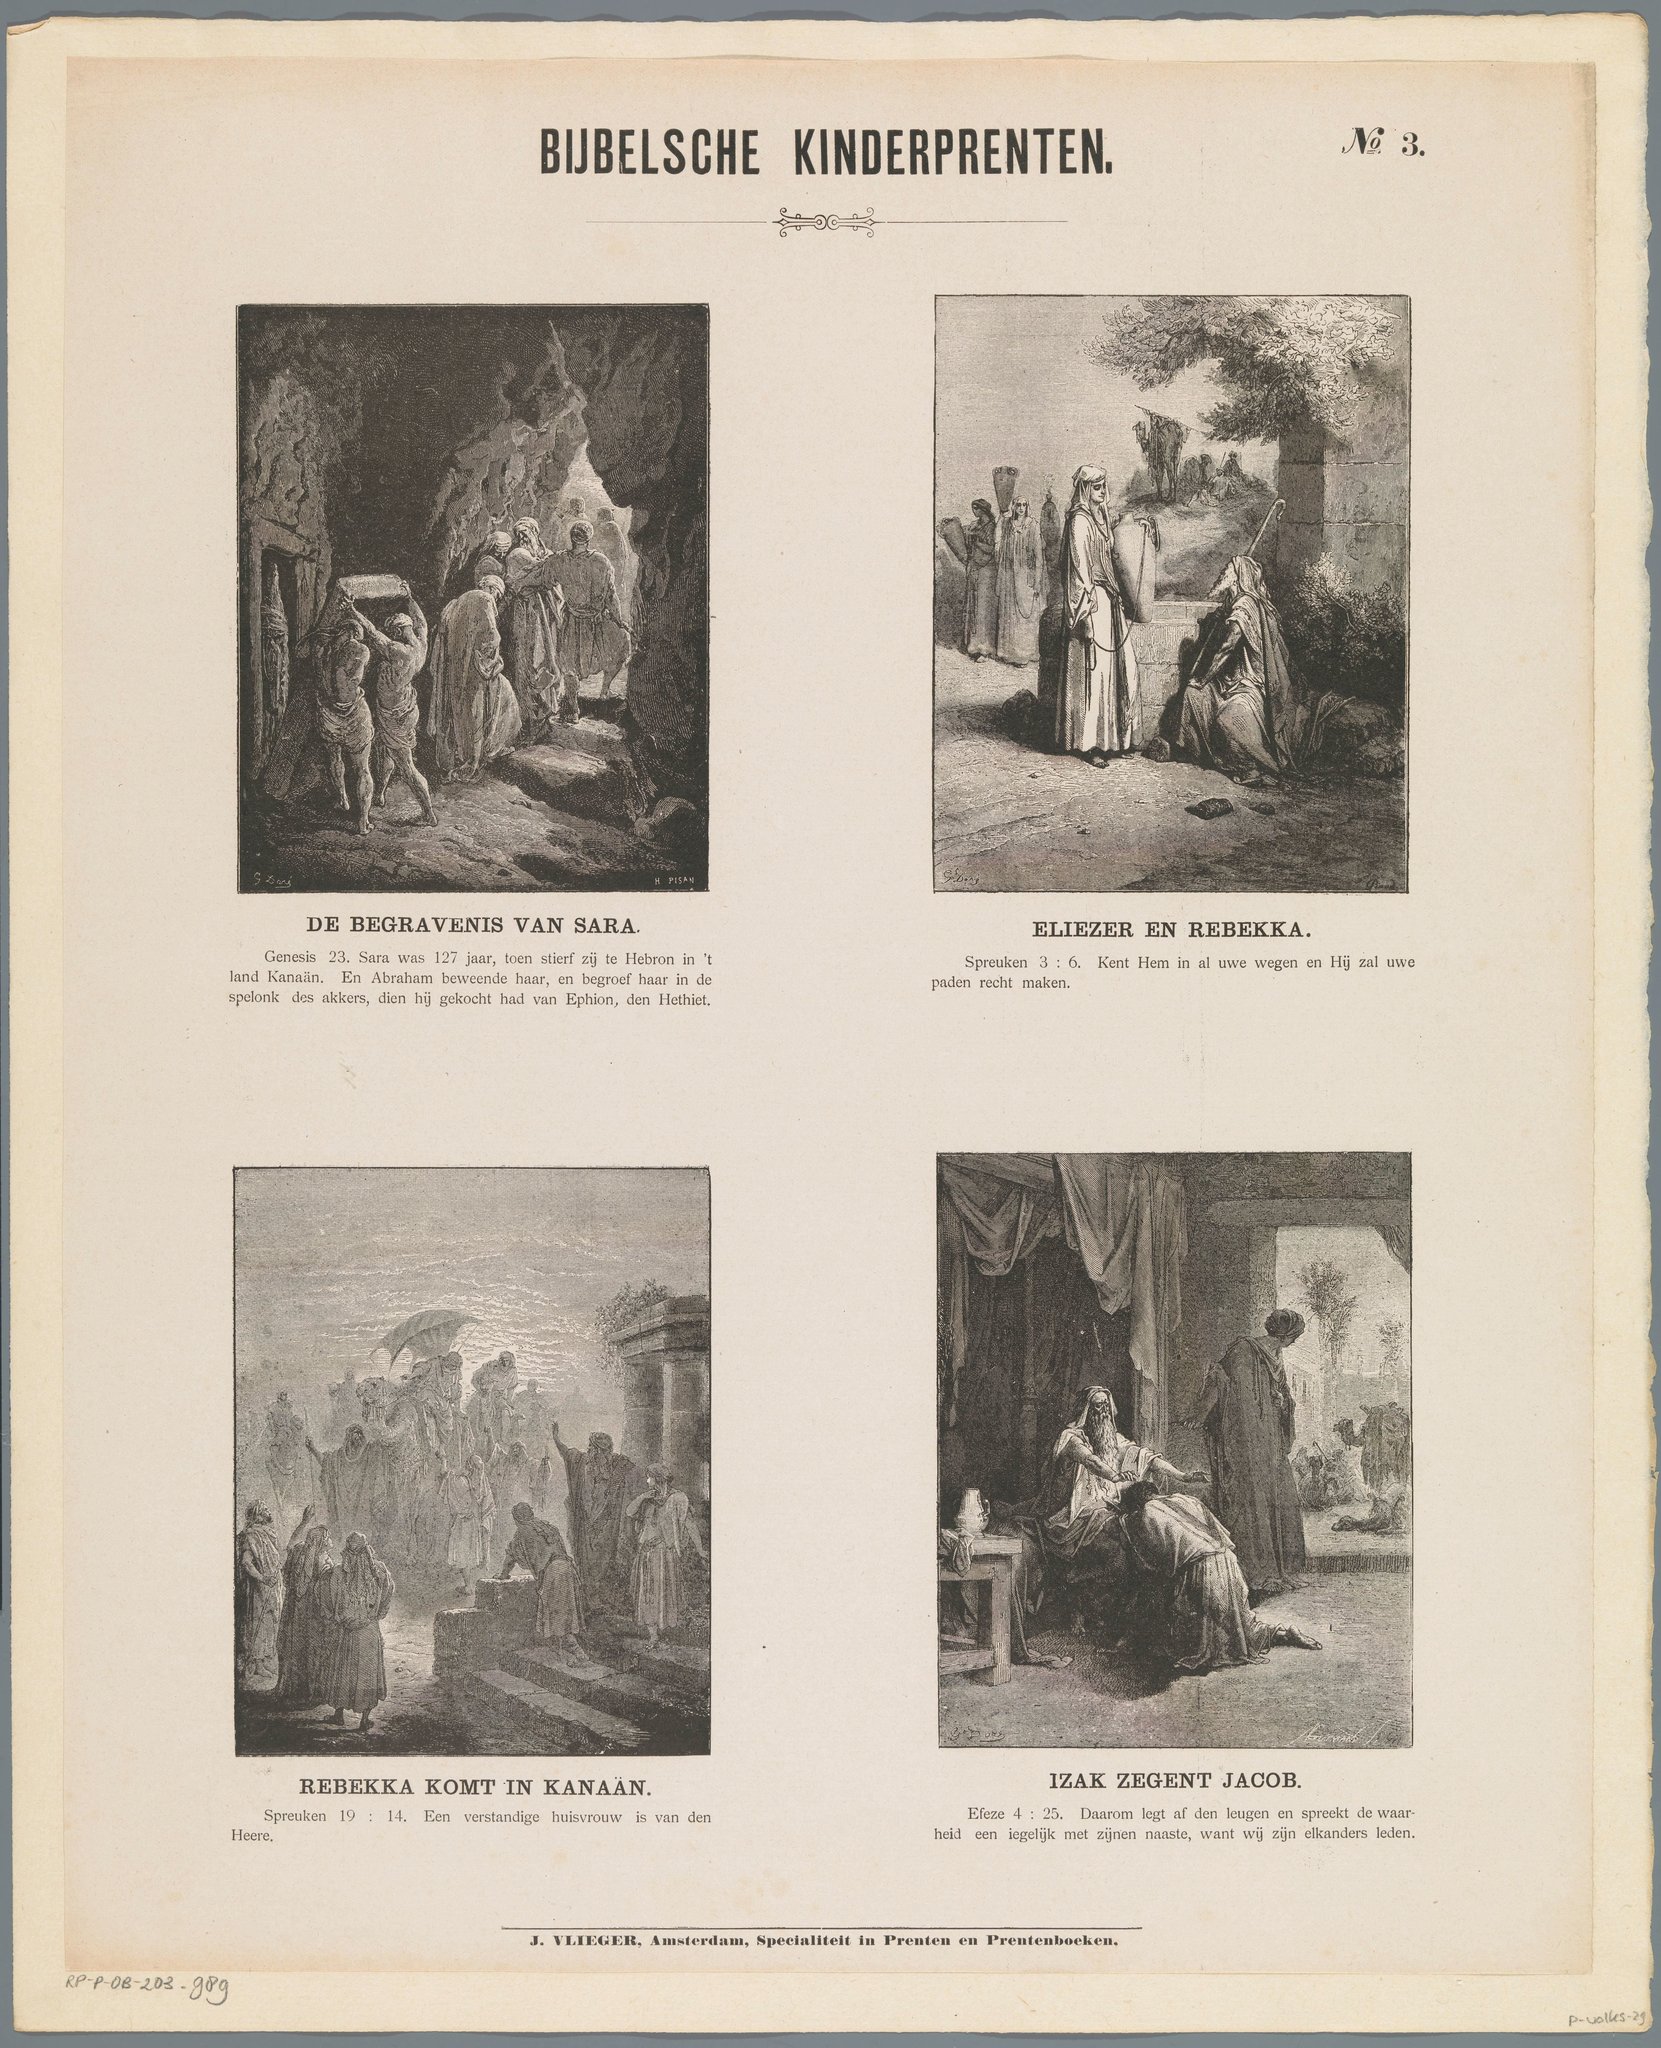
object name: print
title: Bijbelsche kinderprenten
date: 1869-1908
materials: paper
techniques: letterpress printing, photoaquatint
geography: amsterdam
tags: the return journey and arrival in canaan (eliezer and rebekah), isaac's blessing (of jacob and esau) (genesis 27), old testament, rebekah offers eliezer a drink from her pitcher, sarah's burial in the cave of machpelah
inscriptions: collector's mark: Lugt 2760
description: Blad met 4 voorstellingen van verhalen uit het Oude Testament. De begrafenis van Sara, Rebekka en Eliziër bij de bron, Rebekka arriveert in Kanaän en Isaak zegent Jakob. Onder elke afbeelding een Bijbeltekst. Genummerd rechtsboven: No. 3.